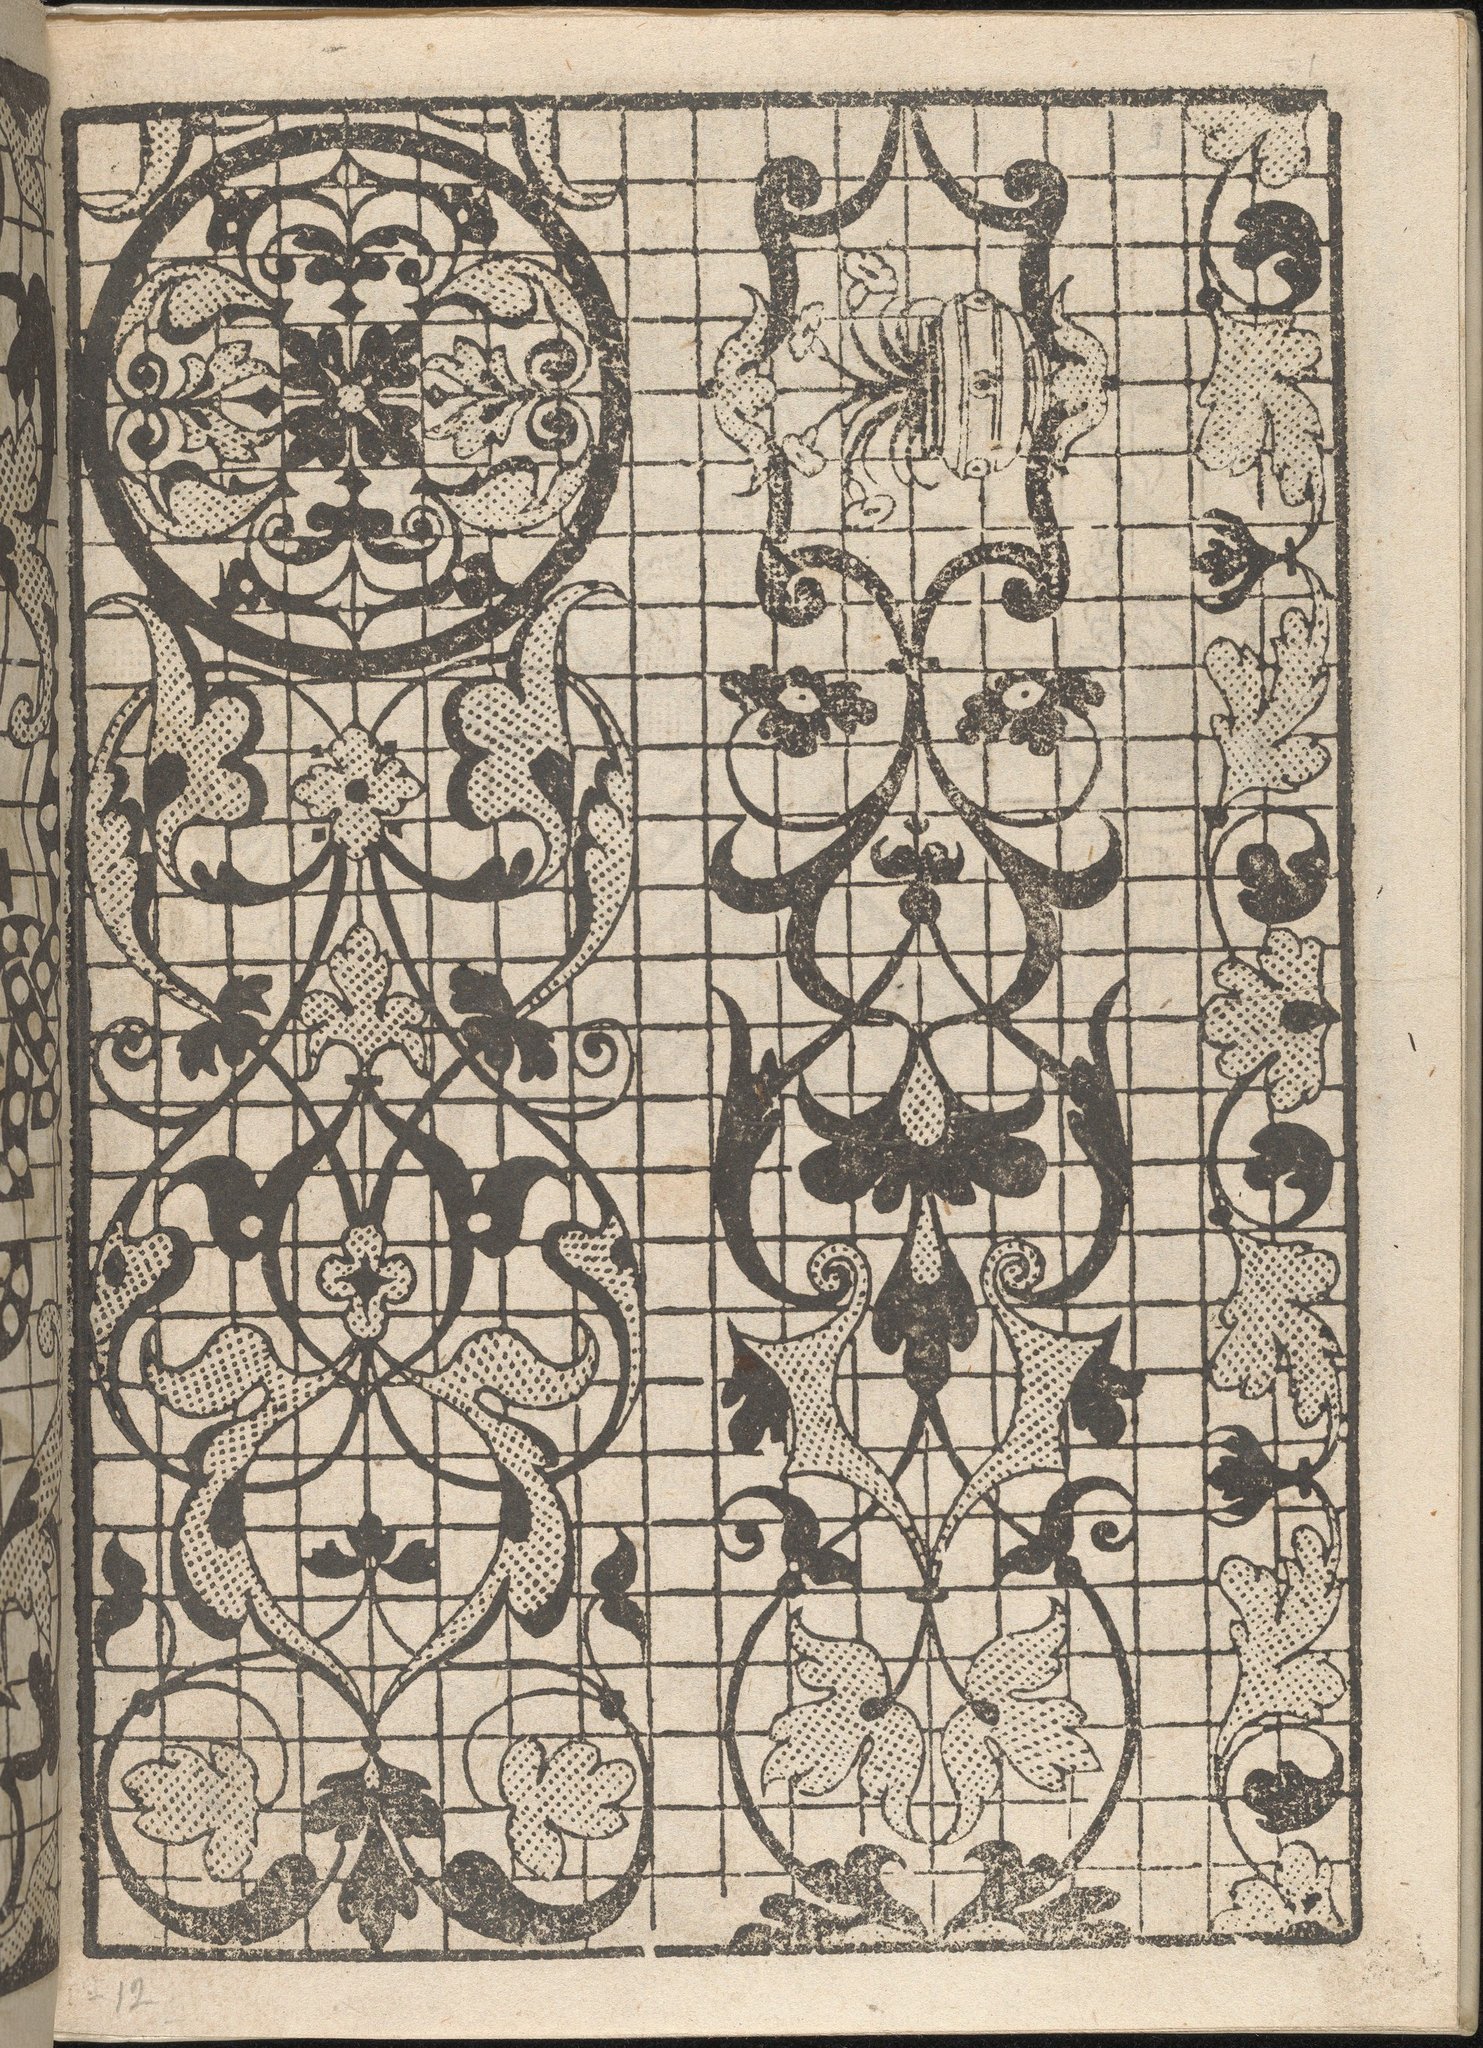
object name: book print ornament architecture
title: Splendore delle virtuose giovani, page 6 (verso)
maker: iseppo foresto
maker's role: designer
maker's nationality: italian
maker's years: 1520-1580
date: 1564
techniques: woodcut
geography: italy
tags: flowers